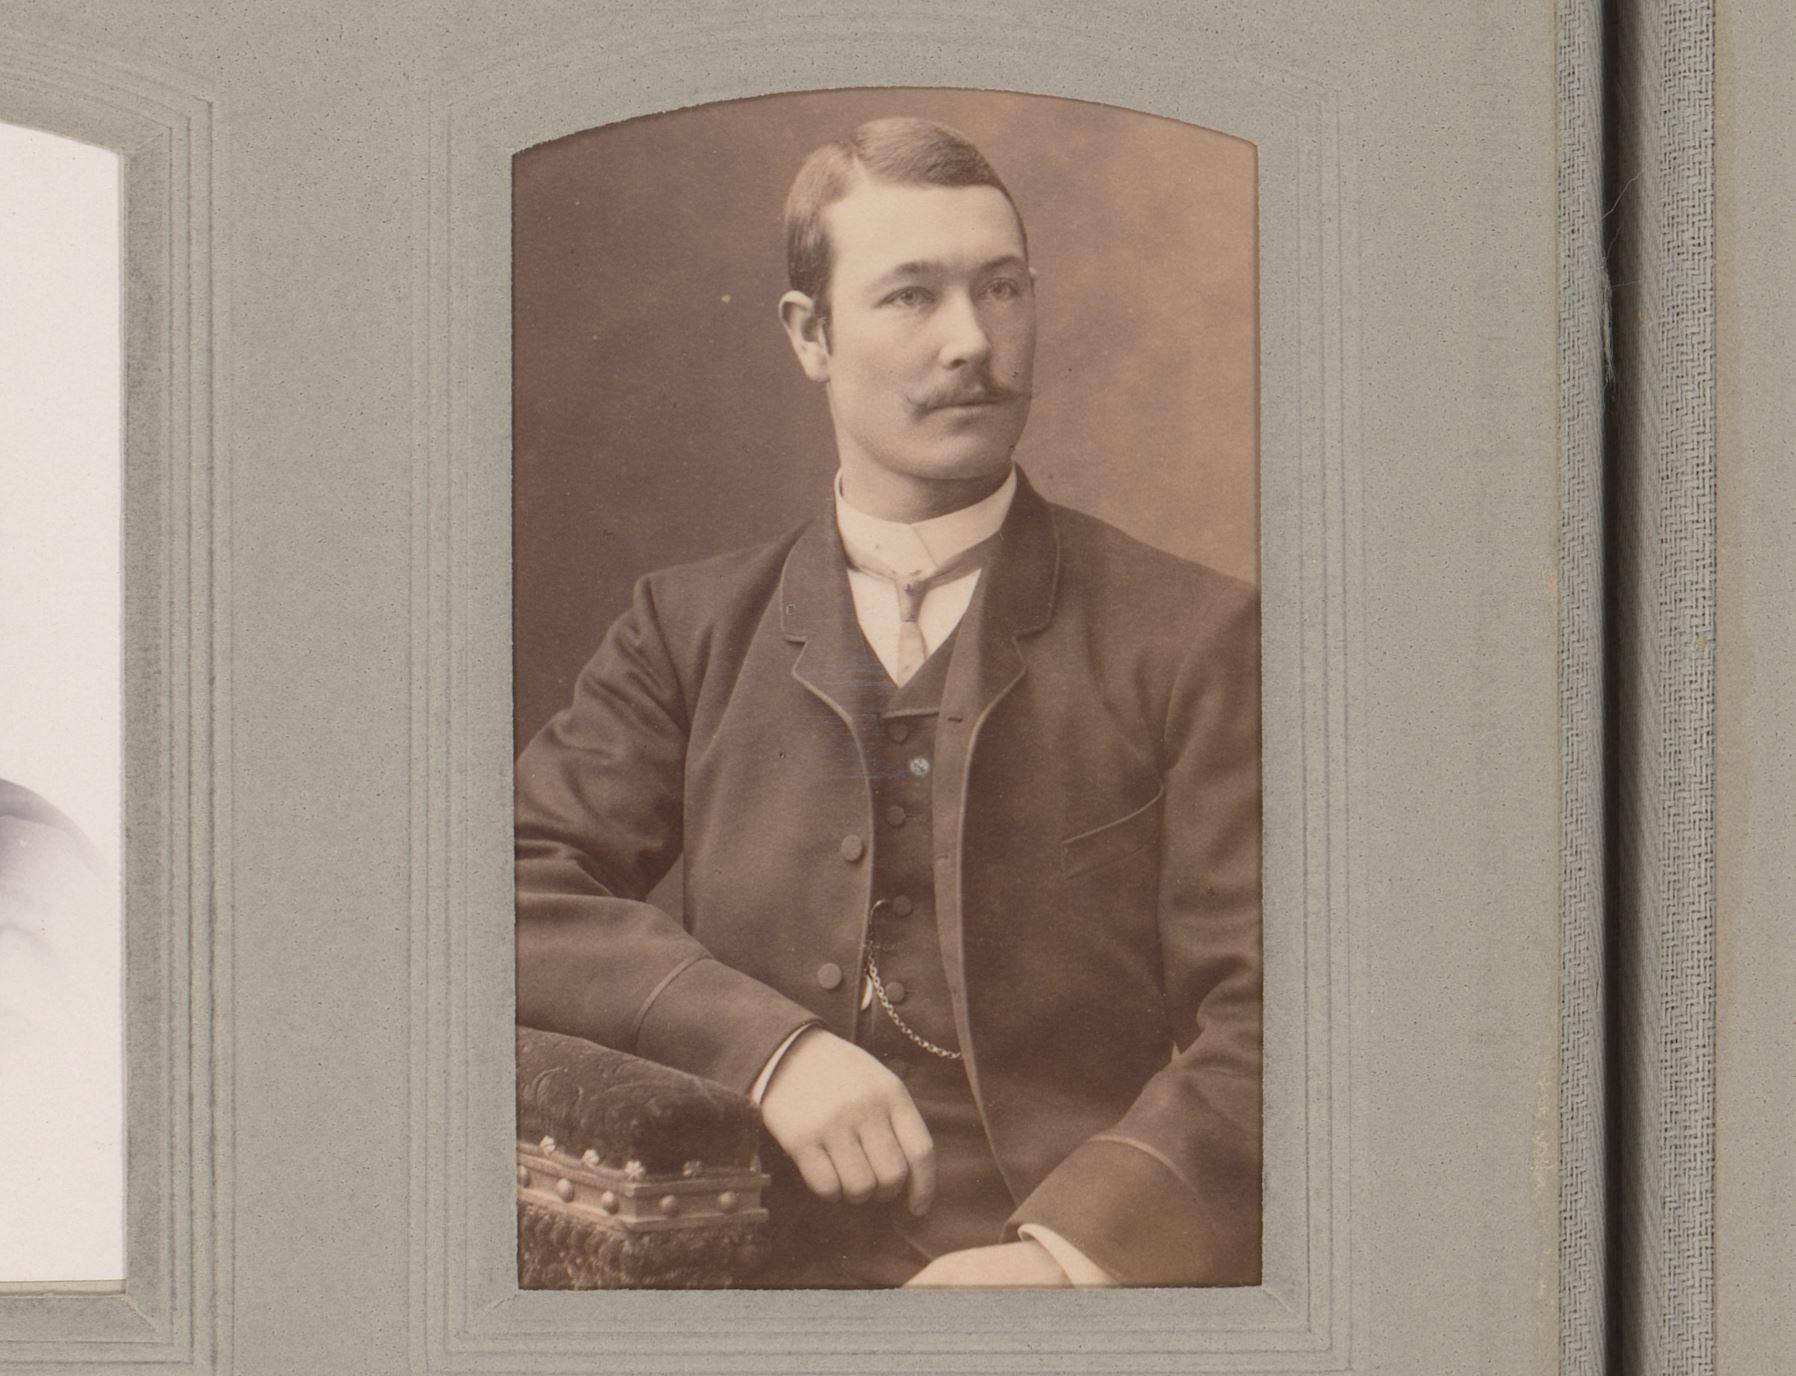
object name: photograph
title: Portret van een zittende man met snor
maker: gustaf alfred johanson dahllöf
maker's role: fotograaf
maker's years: 1841-1908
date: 1860-1900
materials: cardboard, photographic support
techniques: albumen print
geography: stockholm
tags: sitting figure - aa - female human figure, moustache, historical persons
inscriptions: inscription: ‘TELEFON No 4454./ Alfr. Json Dahllöf/ Stockholm/ 38, Hamngatan 38./ Plåten förvaras för efterbeställning.’